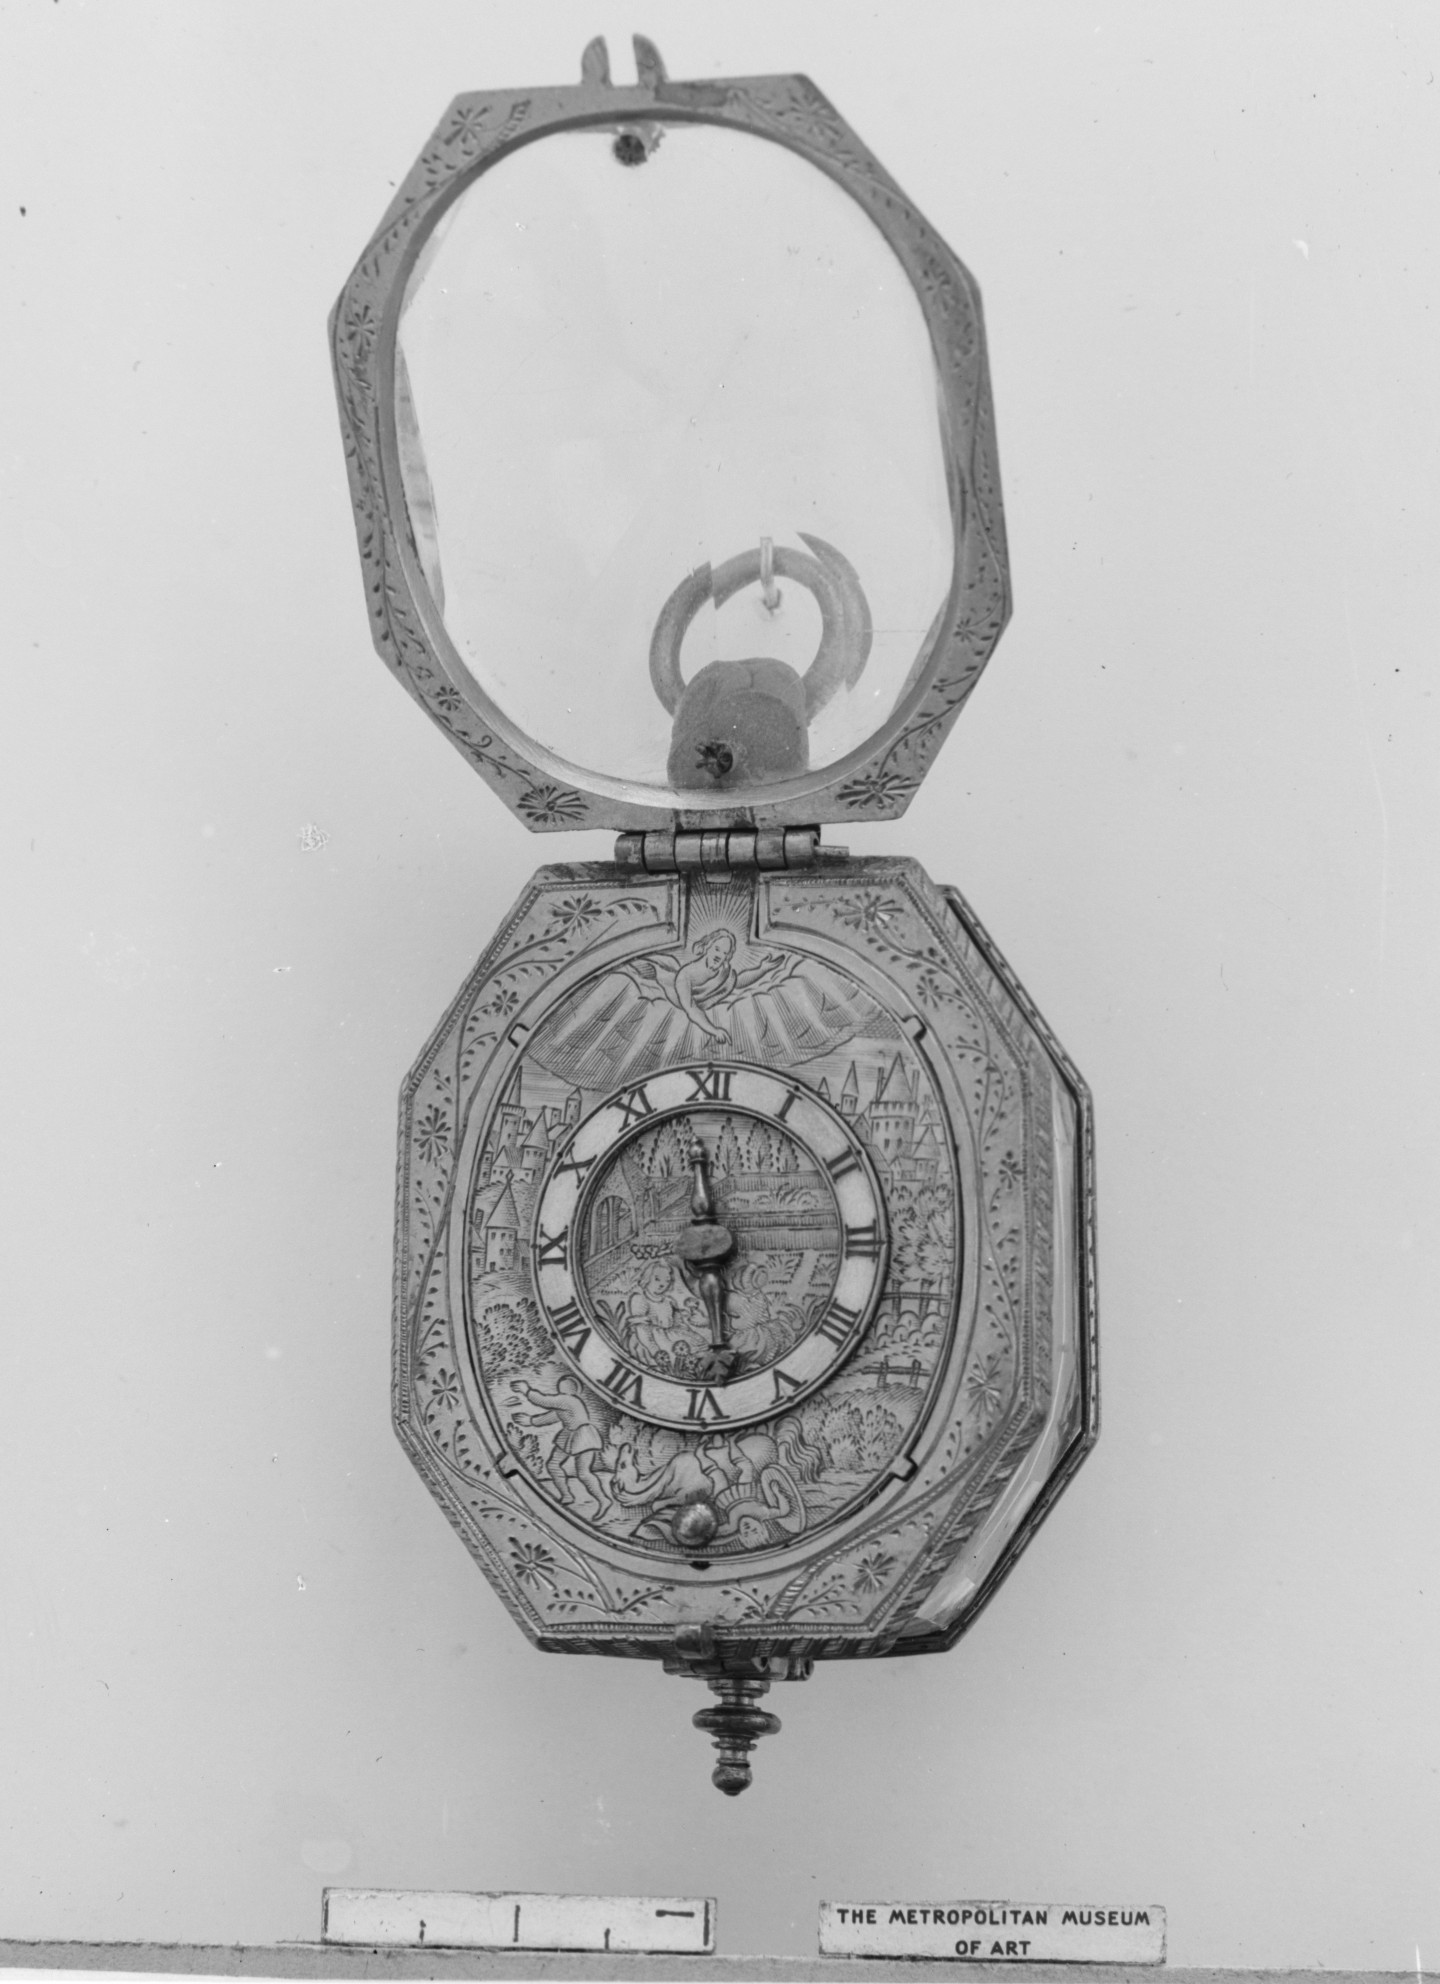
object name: watch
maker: johan georg reinhold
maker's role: maker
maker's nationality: german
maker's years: 1610-1673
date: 1643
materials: gilt, metal, quartz, silver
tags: castles,men